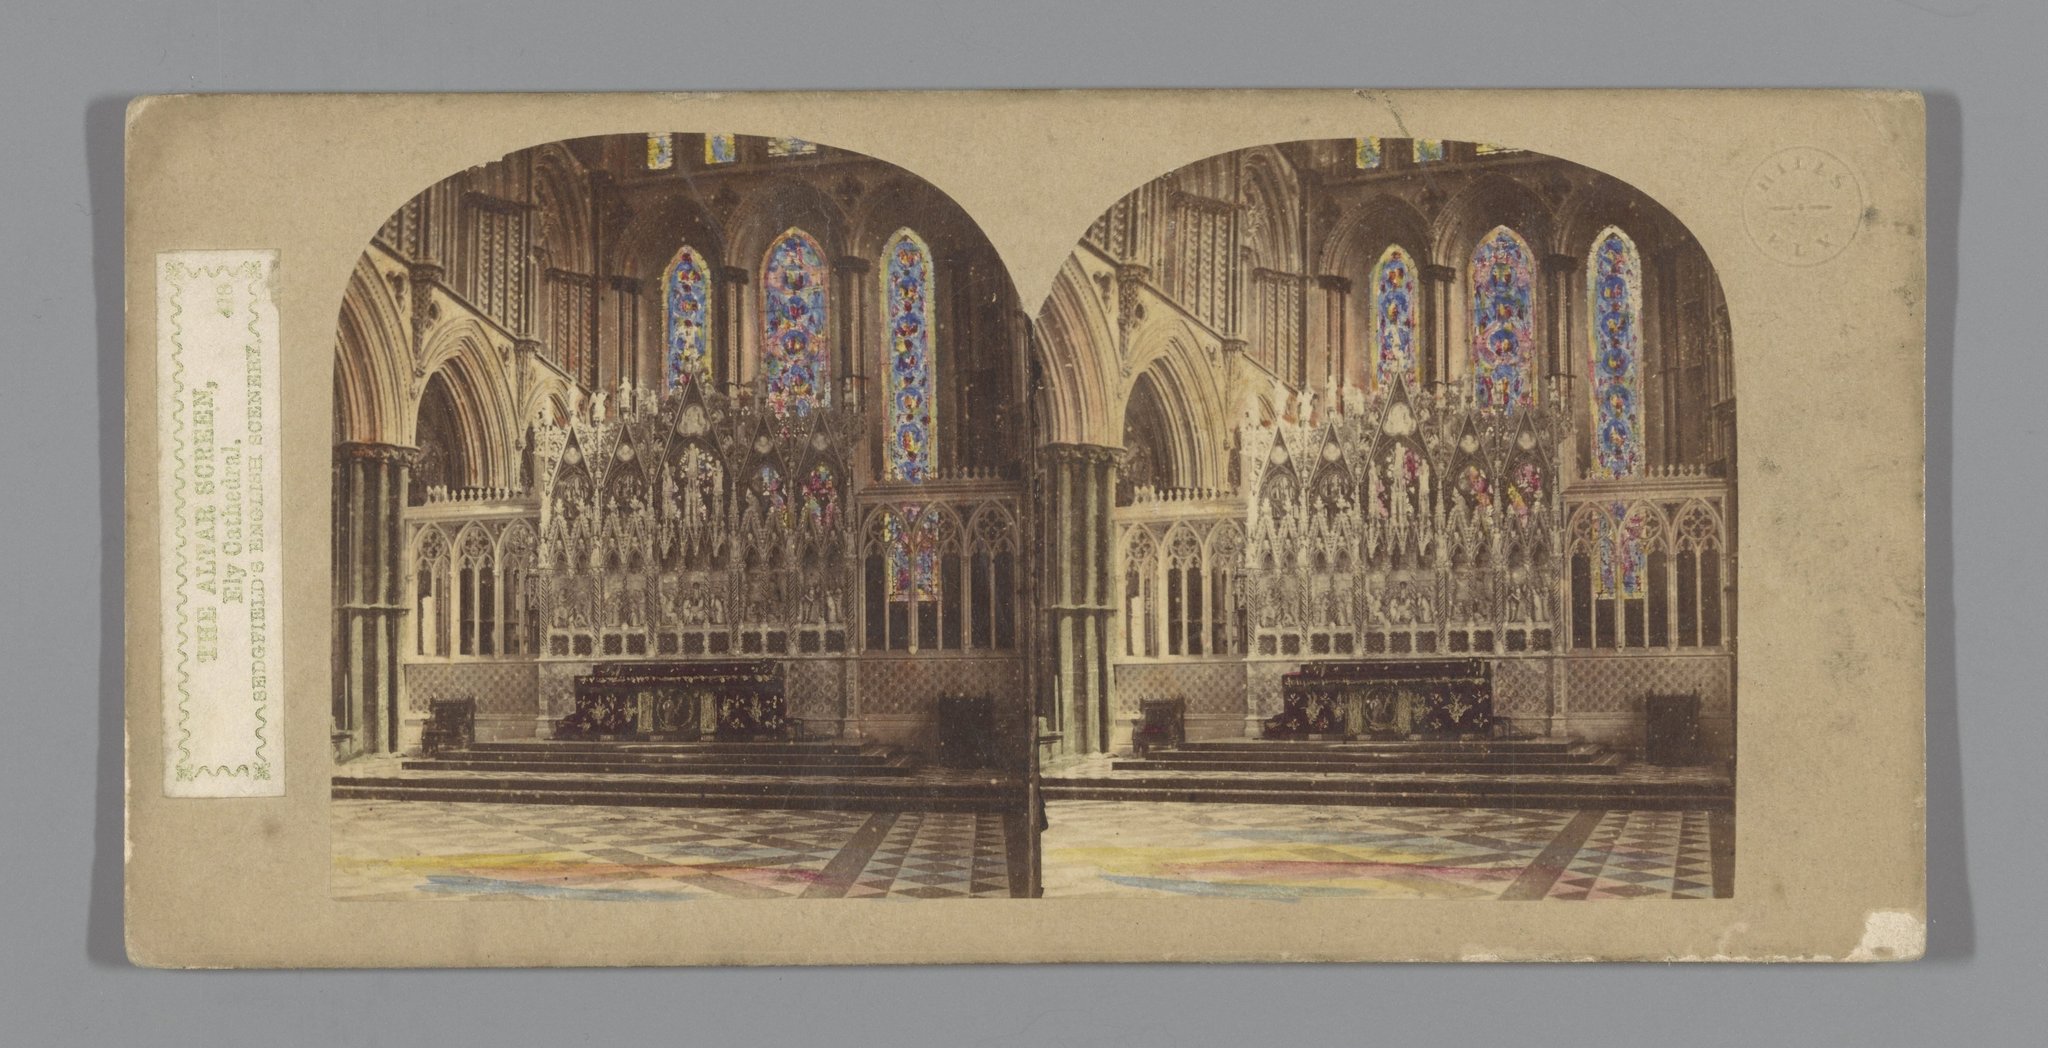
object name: stereograph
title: Retabel van de Kathedraal van Ely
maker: william russell sedgfield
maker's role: fotograaf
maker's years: 1826-1902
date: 1850-1880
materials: cardboard, photographic support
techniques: albumen print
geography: ely cathedral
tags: altar with dossel (dorsal), 'reredos', altar-screen, retable, parts of church interior: choir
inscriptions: inscription: ‘Sedgfield's English Scenery.’, number: ‘418’, inscription: ‘Hills Ely’